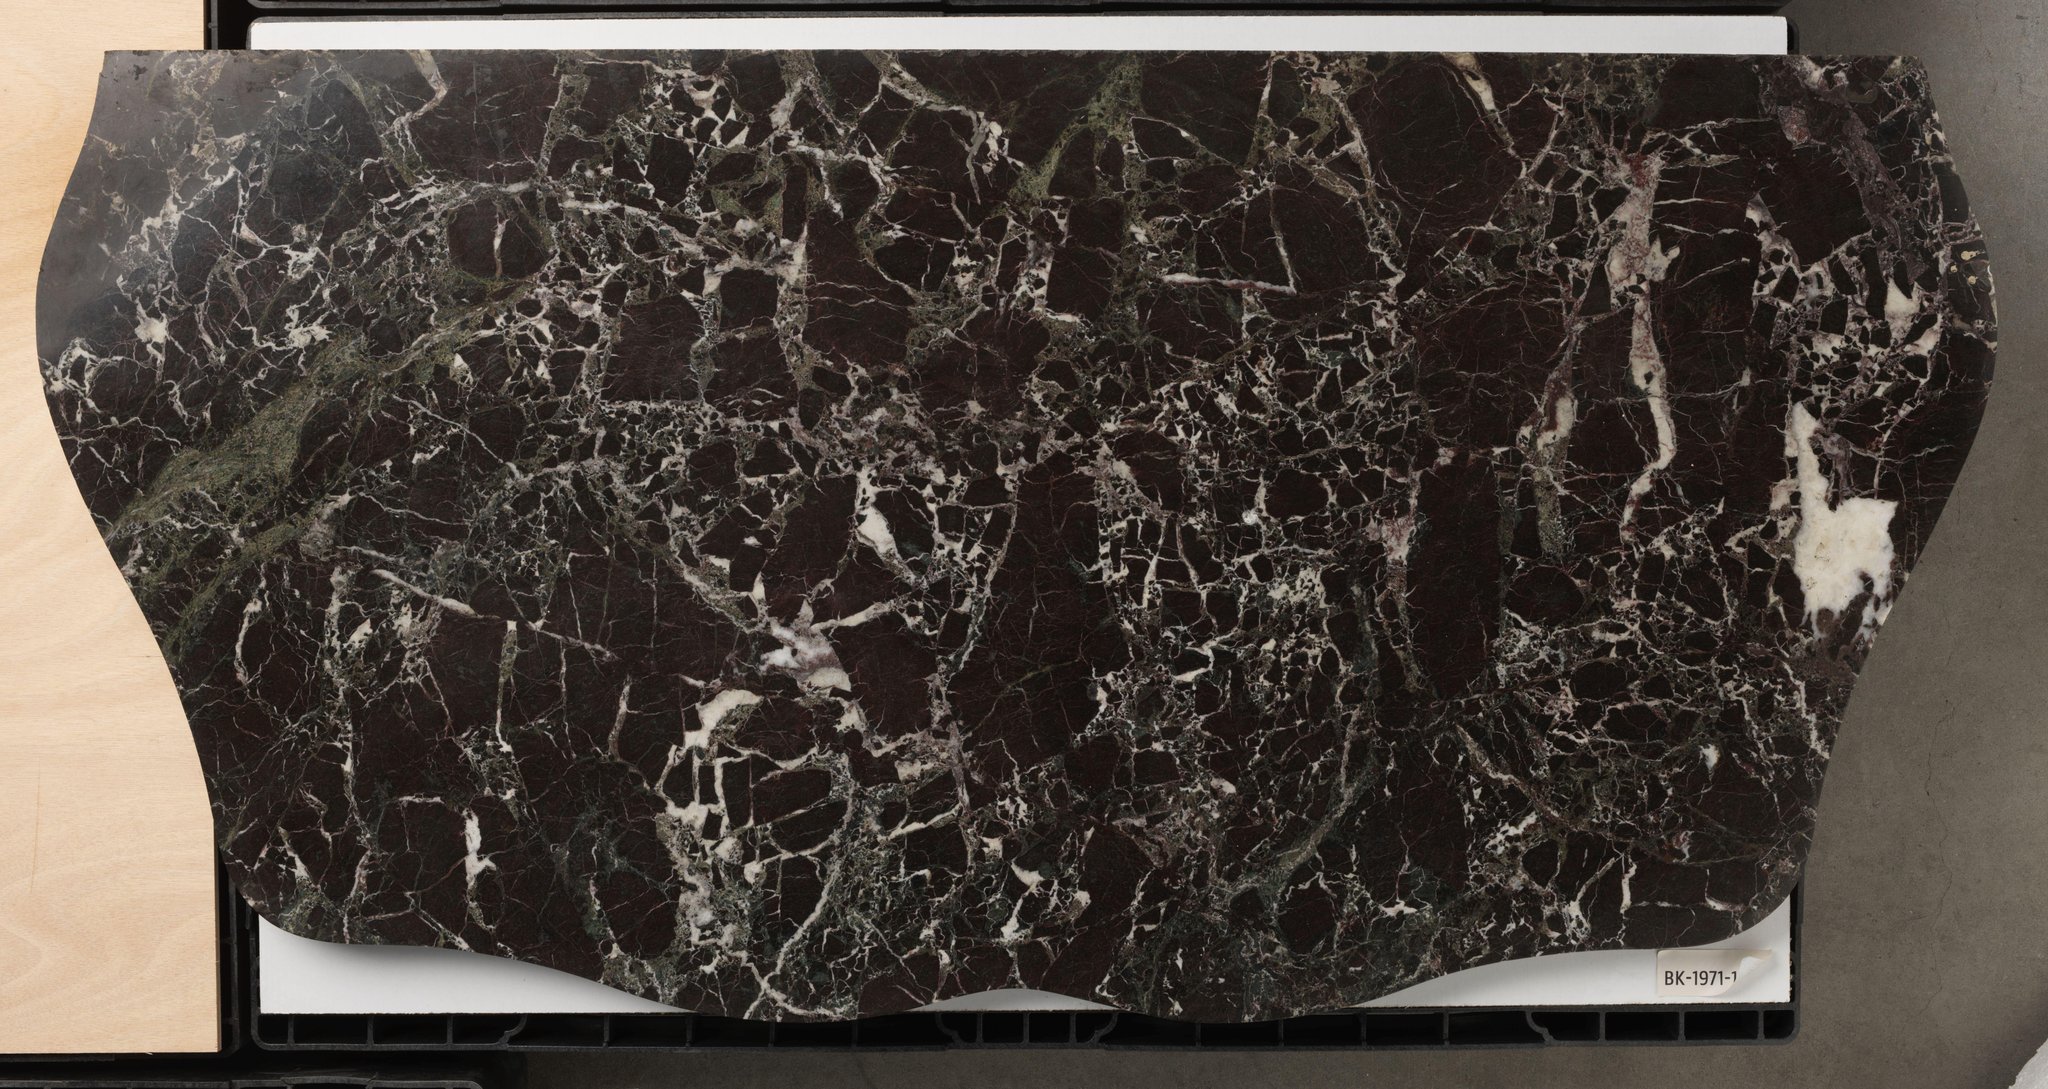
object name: tabletop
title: Tafelblad van zwart marmer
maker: Anonymous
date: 1850-1999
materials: marble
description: Tafelblad van zwart marmer. Aangekocht samen met wandtafel BK-1971-14. Geen oorspronkelijk onderdeel.